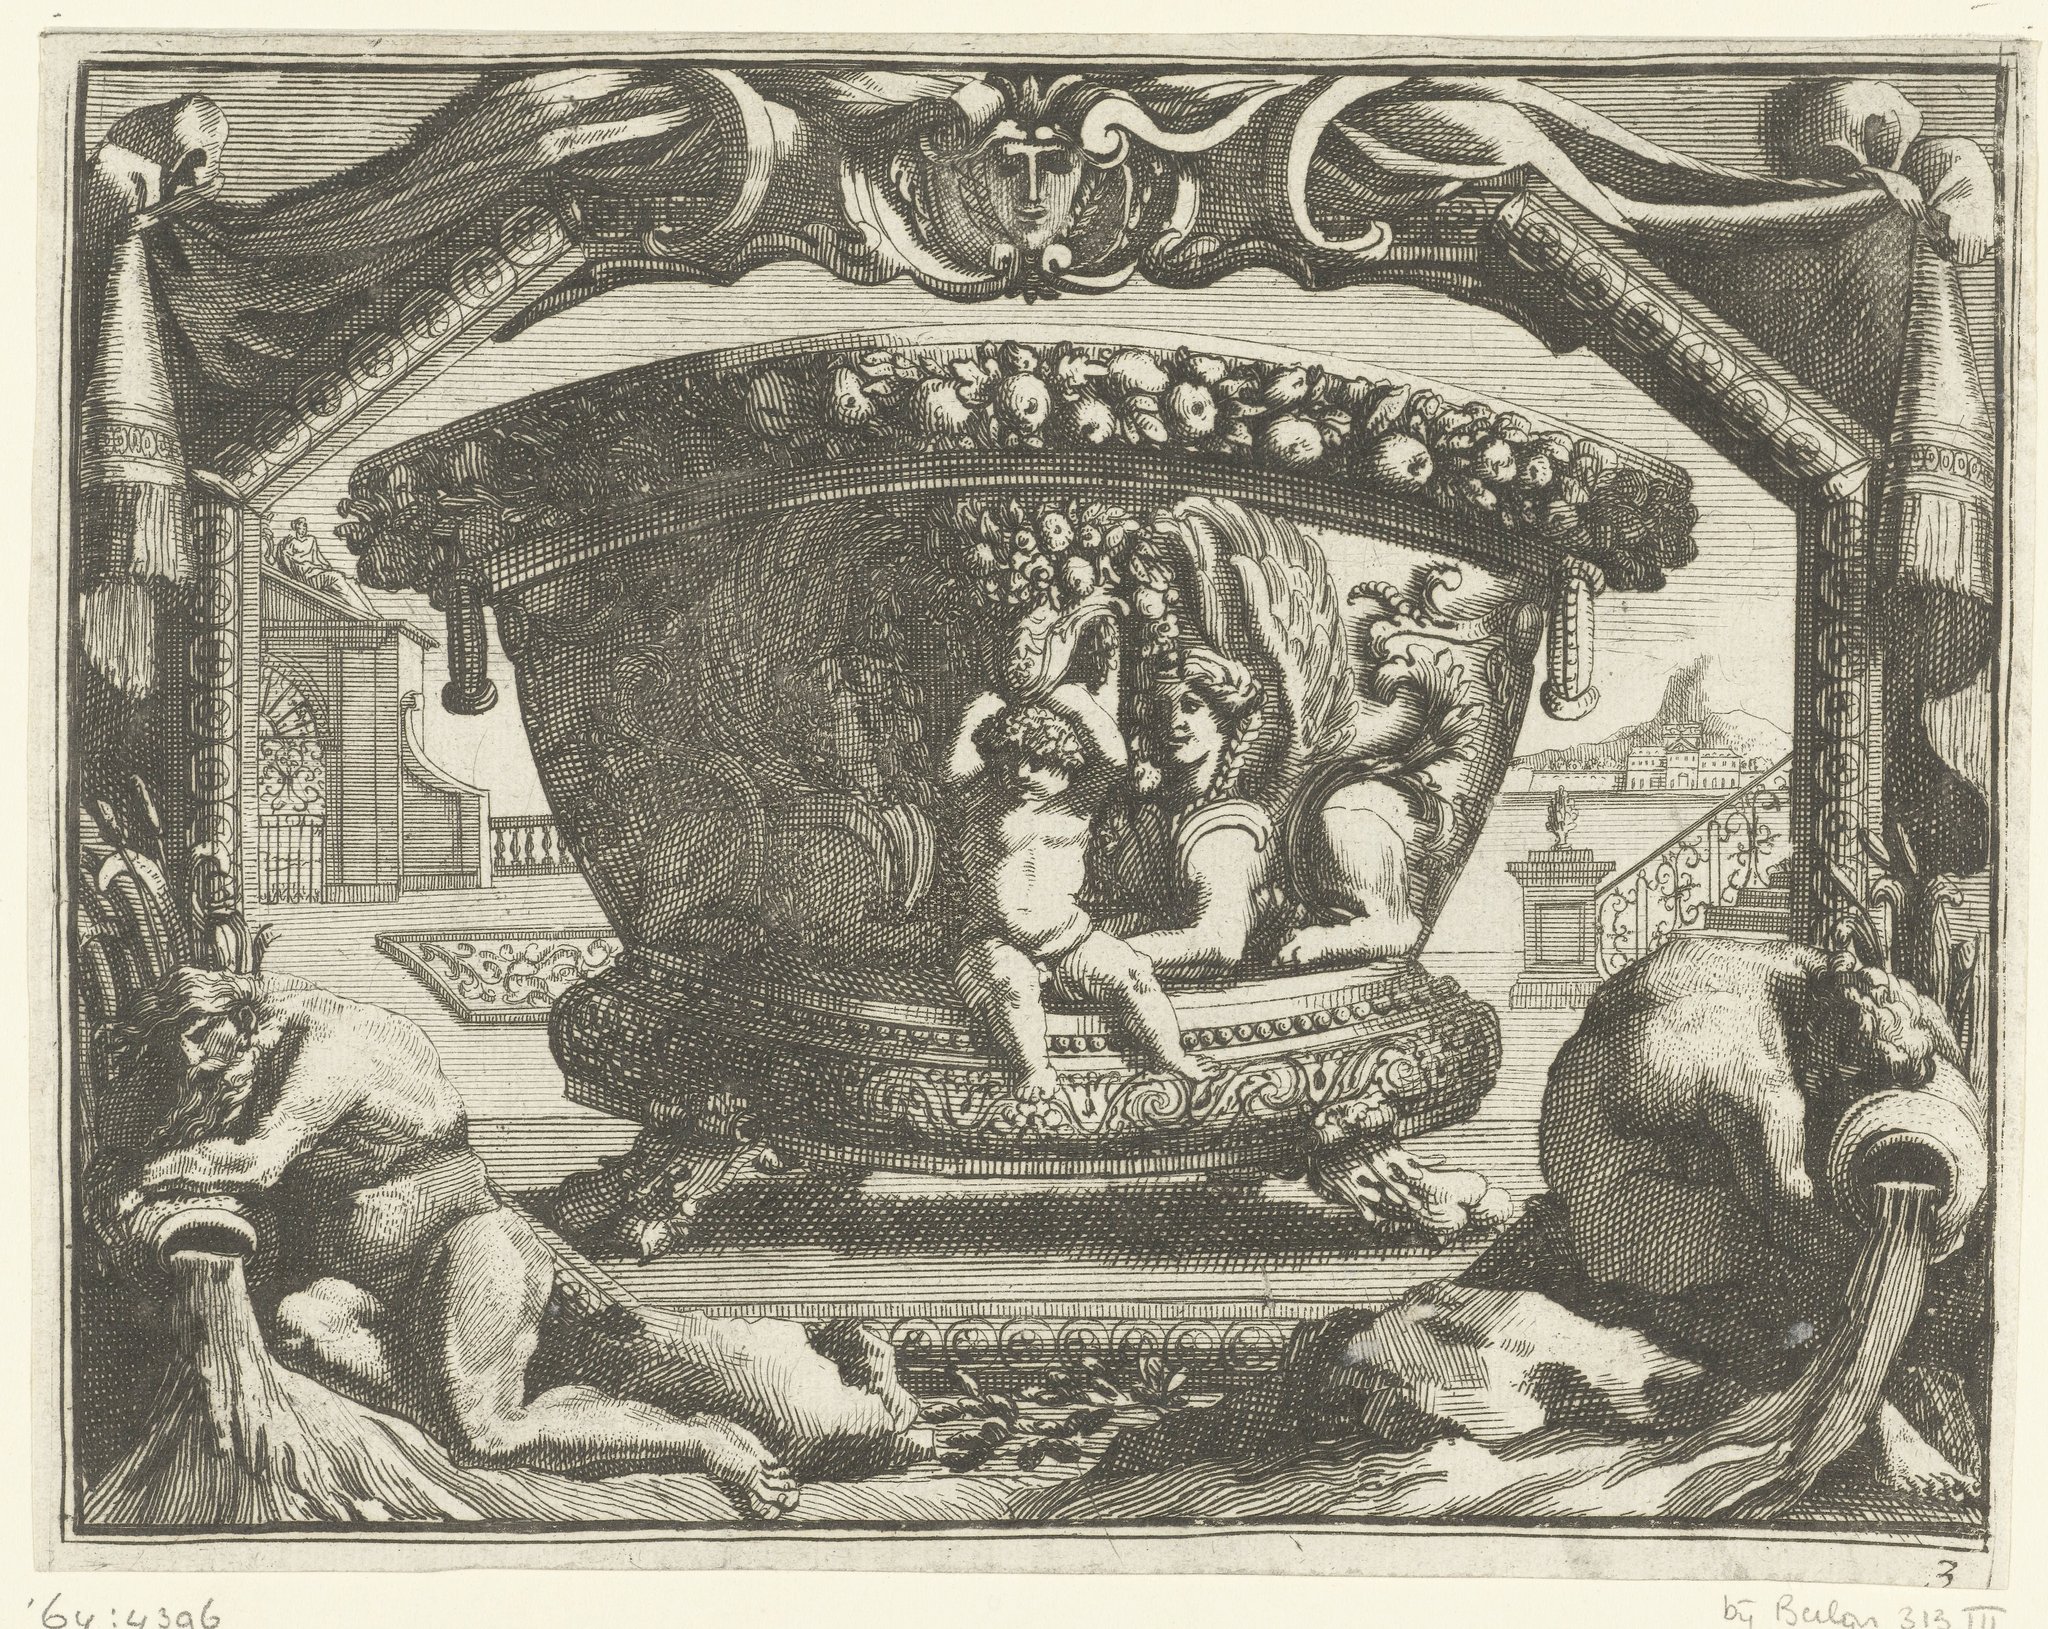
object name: ornament print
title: Bassin met putto geflankeerd door twee sfinxen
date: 1628-1682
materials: paper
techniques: etching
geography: france